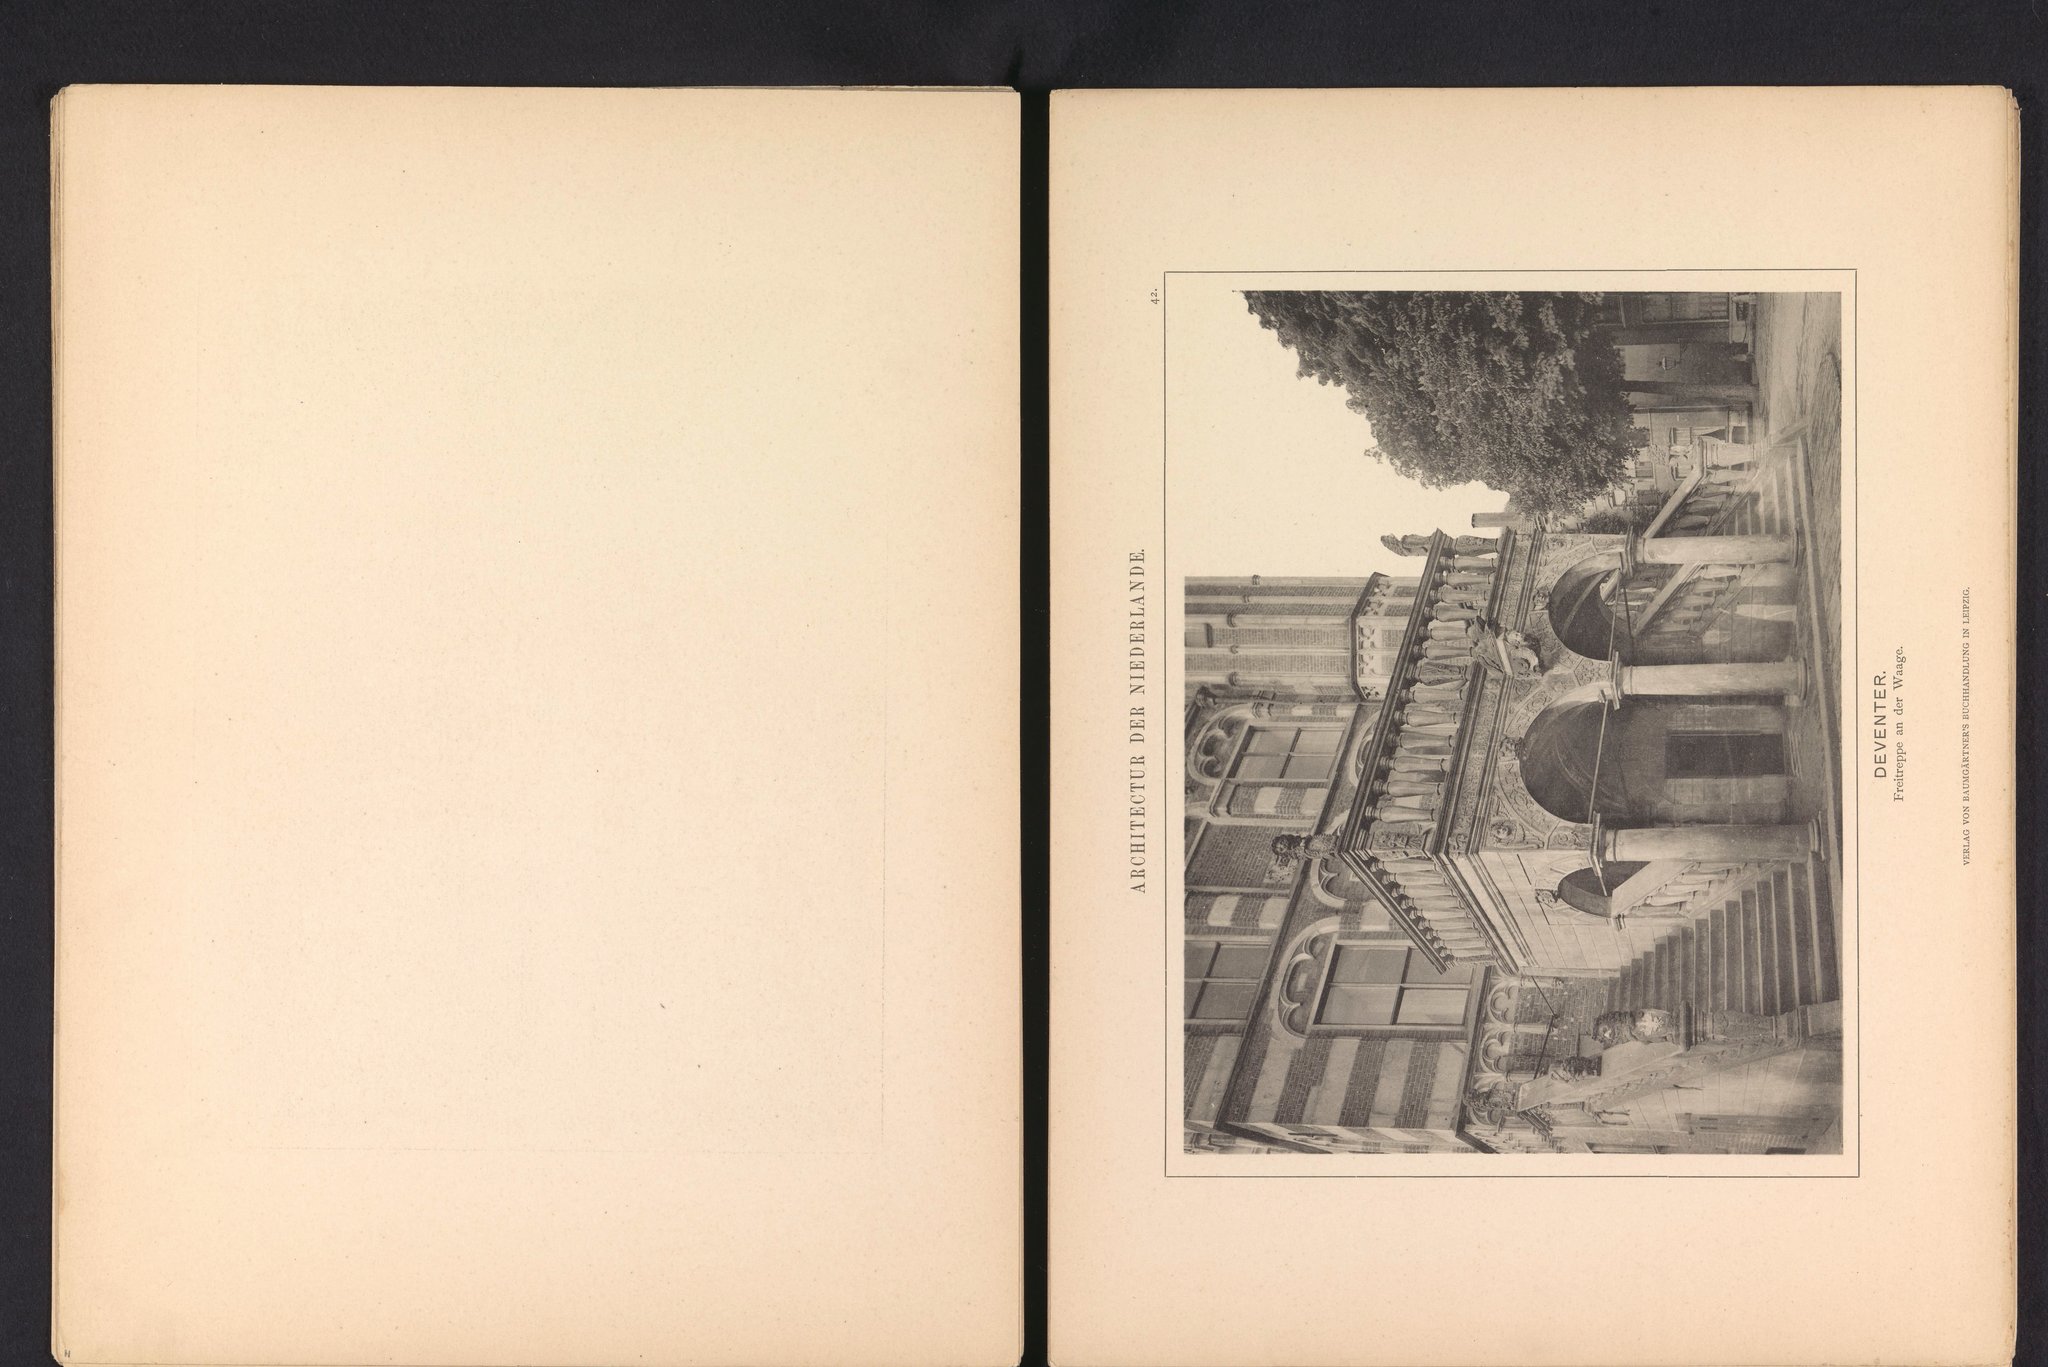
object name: photomechanical print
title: Architectur der Niederlande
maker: Anonymous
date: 1884-1894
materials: paper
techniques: photograph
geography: leipzig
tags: front steps, weigh-house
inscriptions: number: ‘42.’